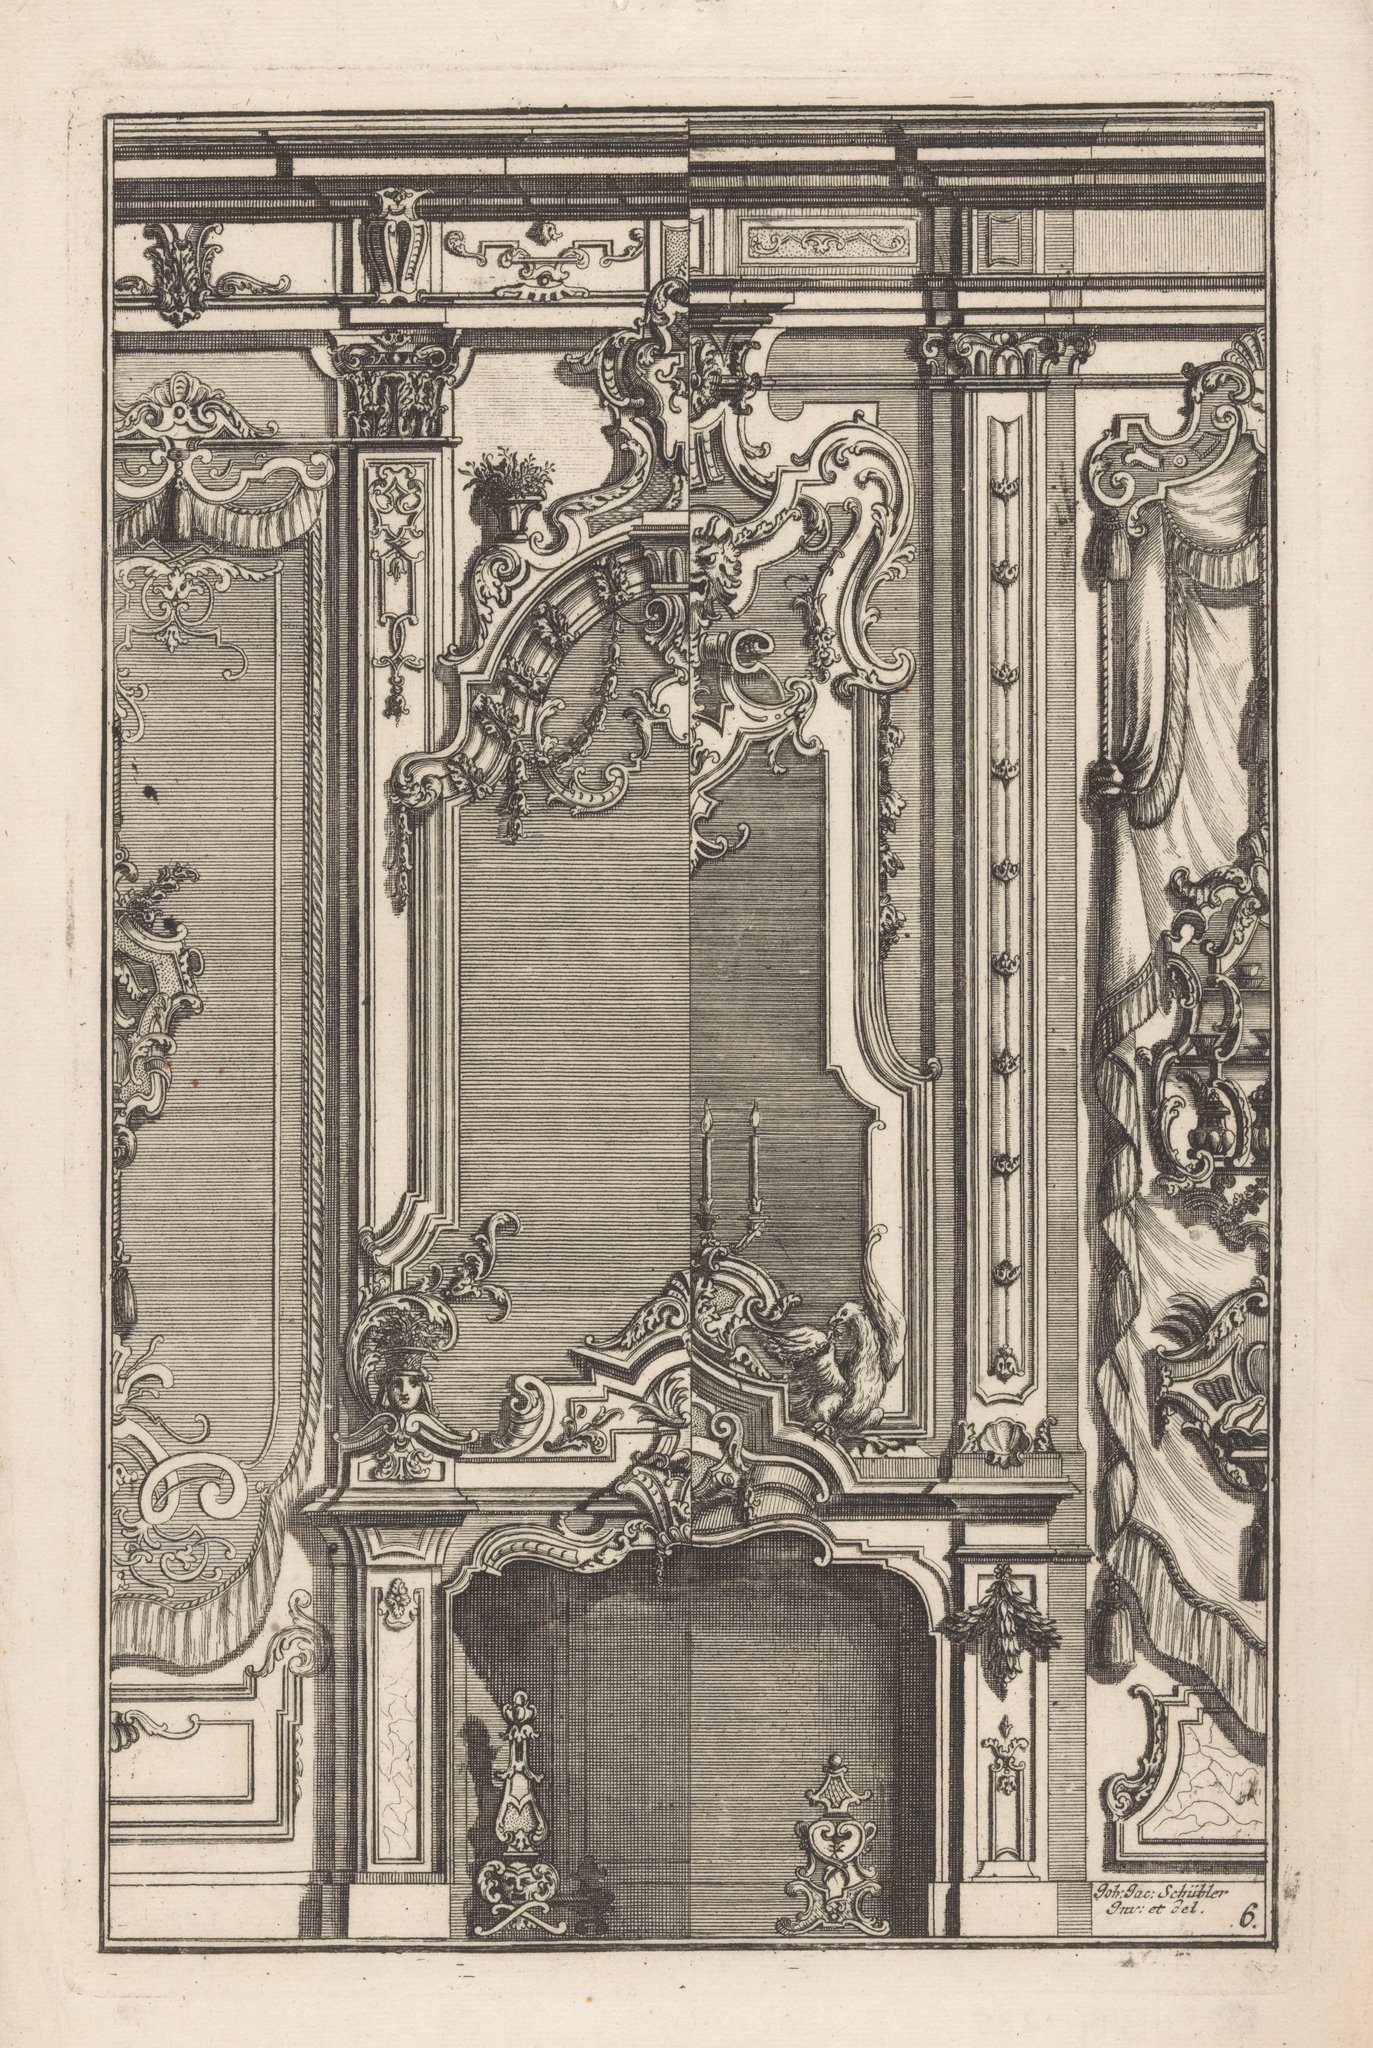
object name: print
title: Nouveau Livre des Chemines (...)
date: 1699-1726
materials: paper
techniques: engraving, etching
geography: nuremberg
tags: predatory birds: eagle, chandelier, candelabrum, open hearth, fire-place, (dinner-)service displayed on sideboard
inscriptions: collector's mark: Lugt 2228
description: Een schouw met rocaille ornamenten, vlechtwerk, een adelaar rechts, een kandelaar in het midden, guirlandes en bloemenmanden. Rechts is de helft van een meubel met servies en draperieën zichtbaar.